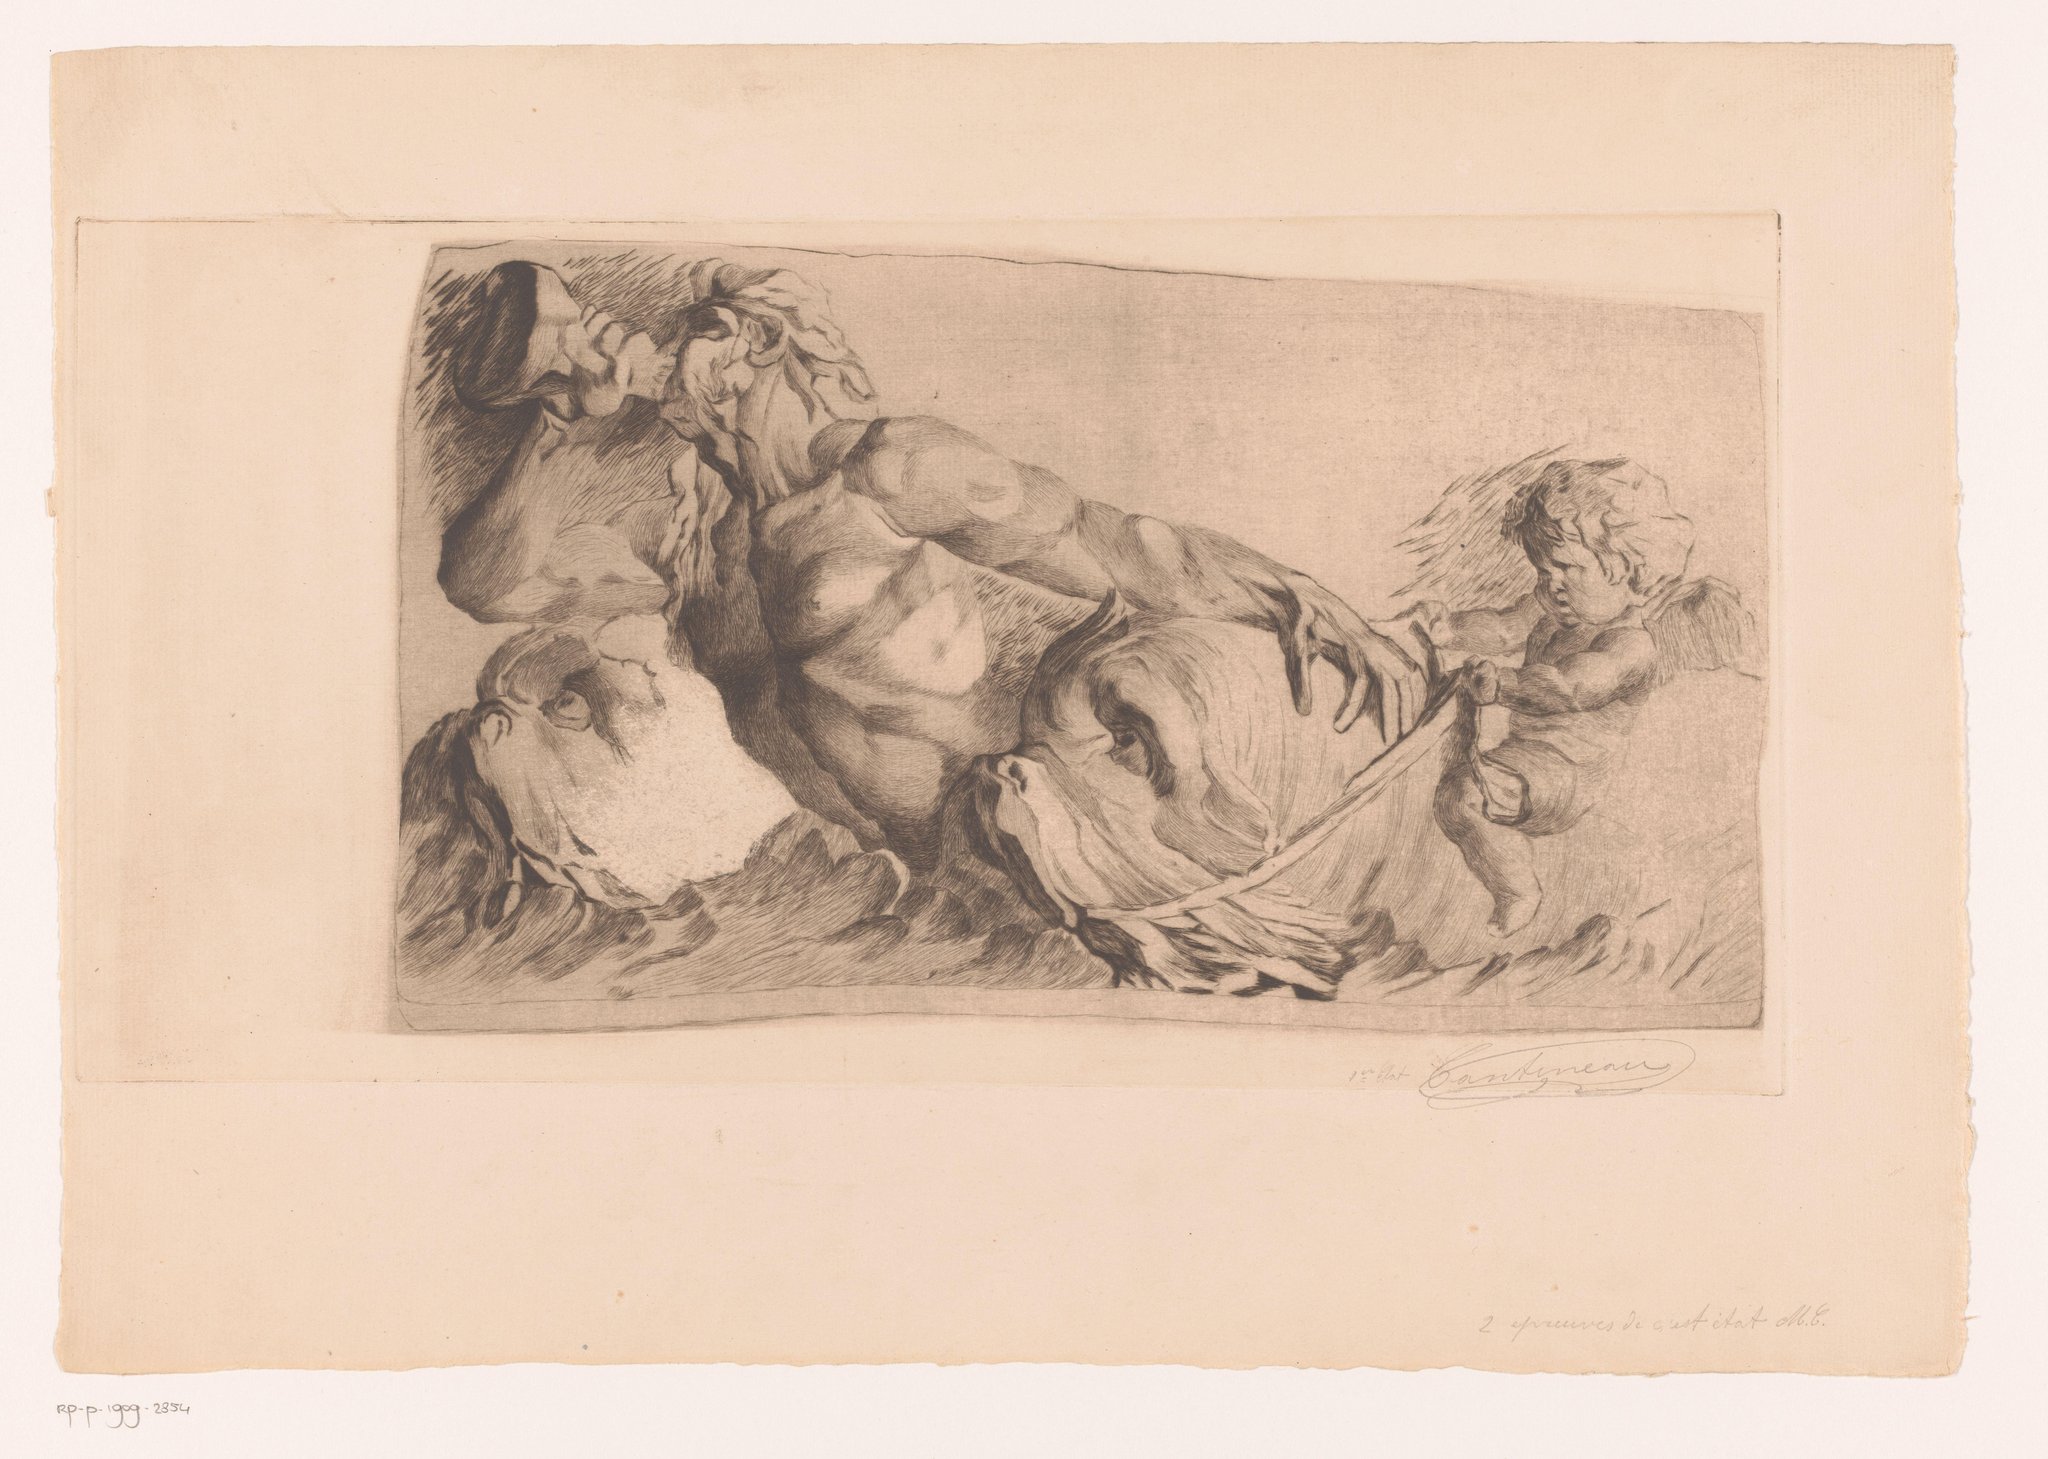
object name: print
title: Op een schelp blazende triton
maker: mary hector rupert cantineau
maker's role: draughtsman, print maker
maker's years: 1875-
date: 1885-1909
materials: paper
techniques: drypoint, etching, intaglio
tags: dolphin ~ ornament, triton(s) (+ attributes)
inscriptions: annotation: ‘Bas reliefs d'apres Carpeaux par Cantineau’, annotation: ‘2 epreuves de c'est état M.C.’, annotation: ‘1er état’, collector's mark: Lugt 2228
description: Kopie naar een bas-reliëf. Sterfdatum prentmaker onbekend. Derhalve is voor bepaling van de rechten van dit object de verwervingsdatum aangehouden.